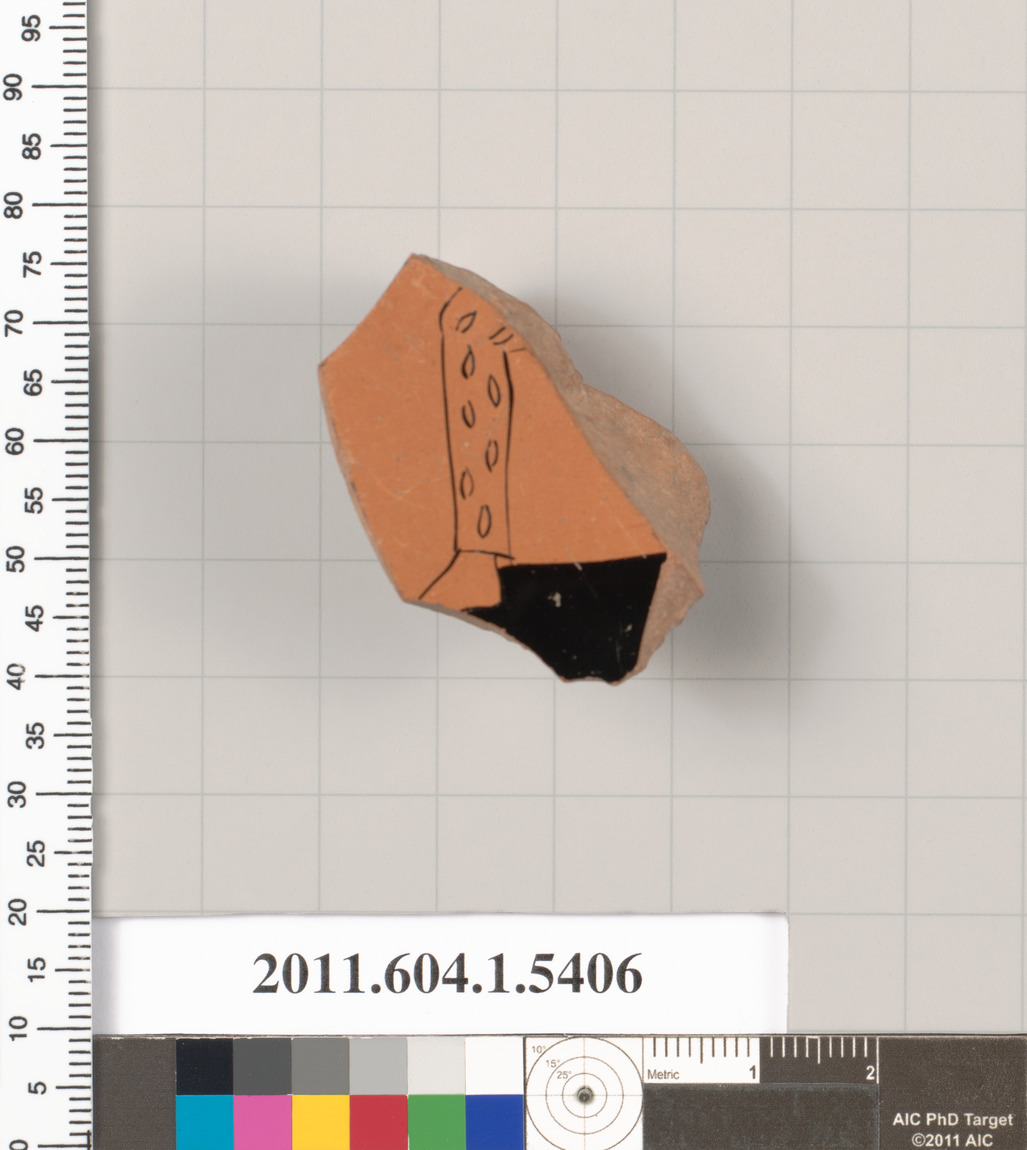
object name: kylix fragment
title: Terracotta fragment of a kylix (drinking cup)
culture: greek, attic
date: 490-480 BCE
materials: terracotta